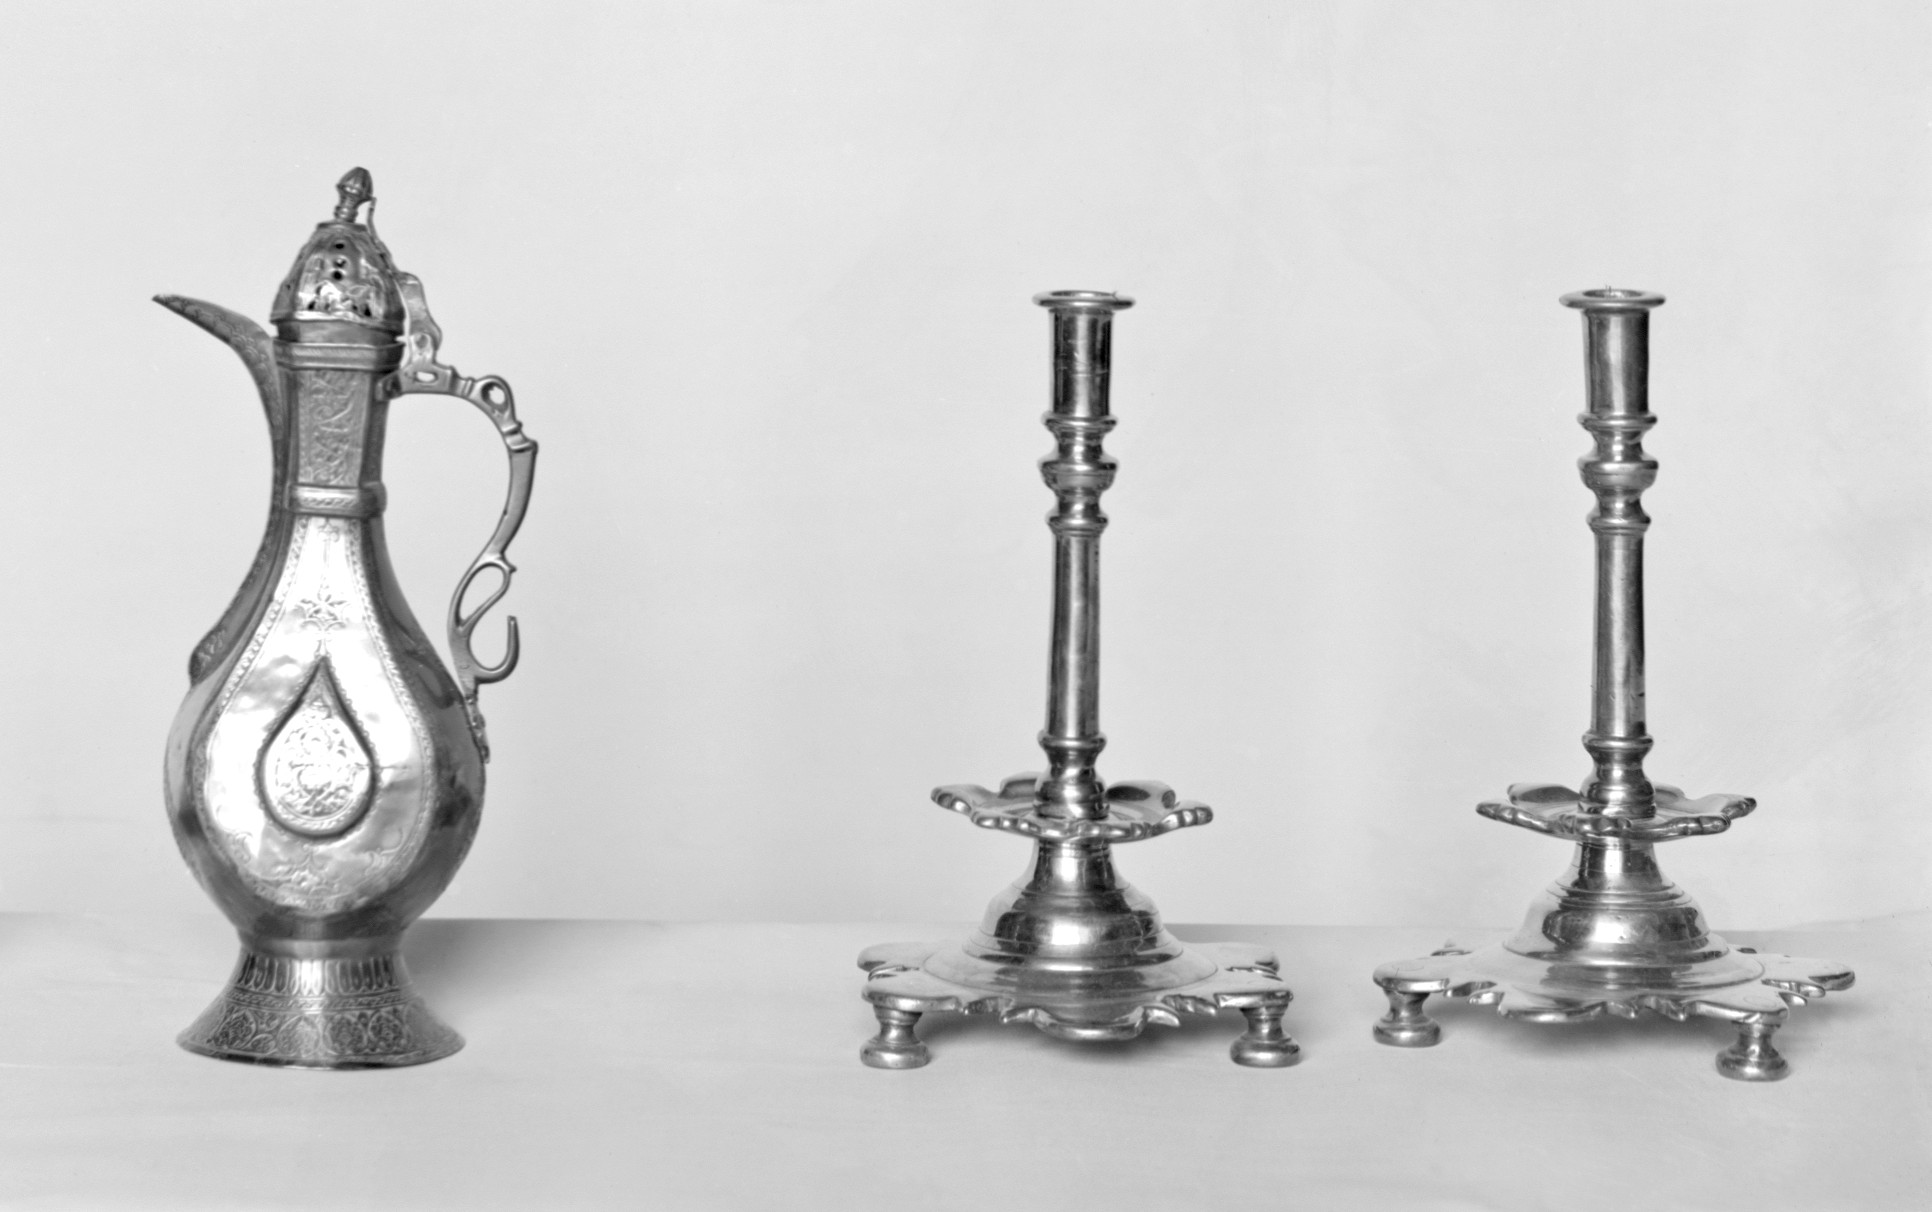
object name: candlestick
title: Pair of candlesticks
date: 1701-1900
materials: brass